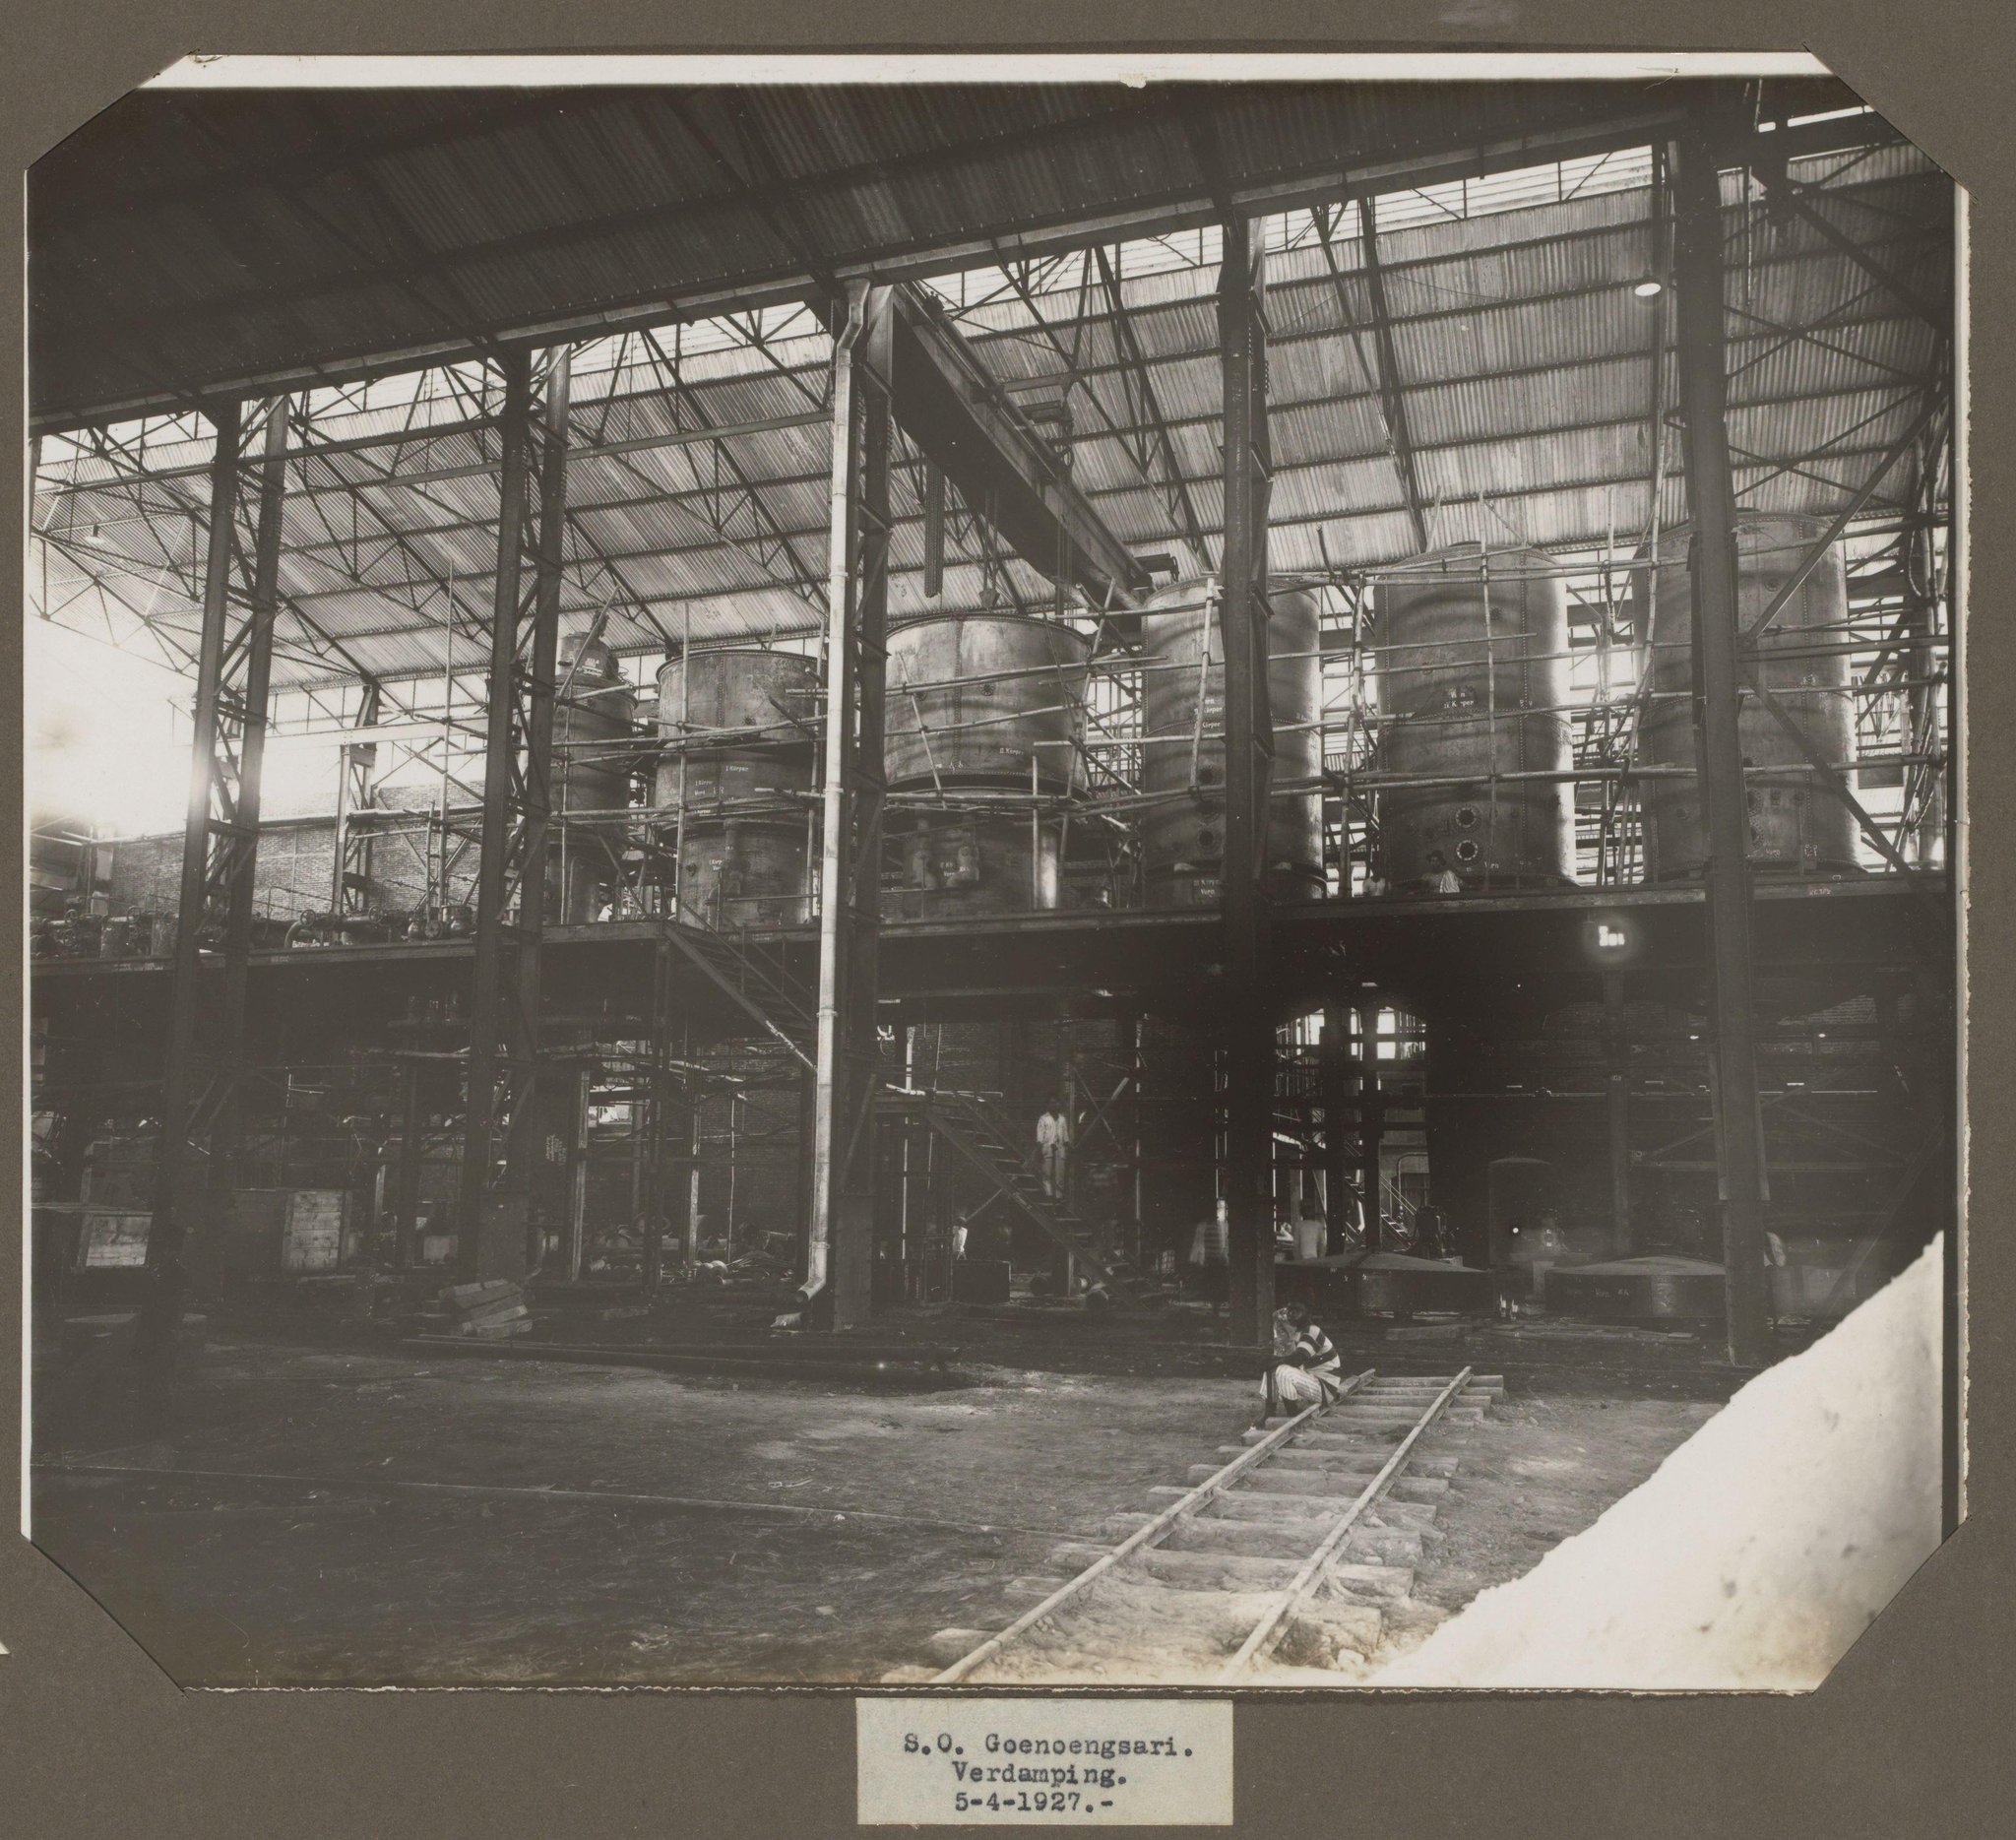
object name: photograph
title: S.O. Goenoengsari. Verdamping. 5-4-1927.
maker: Anonymous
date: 1904-1927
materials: photographic support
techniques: gelatin silver print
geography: east java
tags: colonial system, trade-company, factory-interior, machine shop, making the overground structures (~ building activities), (non-fruit) products of plants or trees: sugarcane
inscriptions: inscription: ‘S.O. Goenoengsari. Verdamping. 5-4-1927.’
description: Interieur van een fabrieksgebouw in aanbouw, april 1927. Met enkele Javaanse bouwvakkers. Onderdeel van het fotoalbum met foto's van de opbouw van de suikerfabriek te Goenoengsari op Oost-Java door de Handels Vereniging Amsterdam 1926-1927.